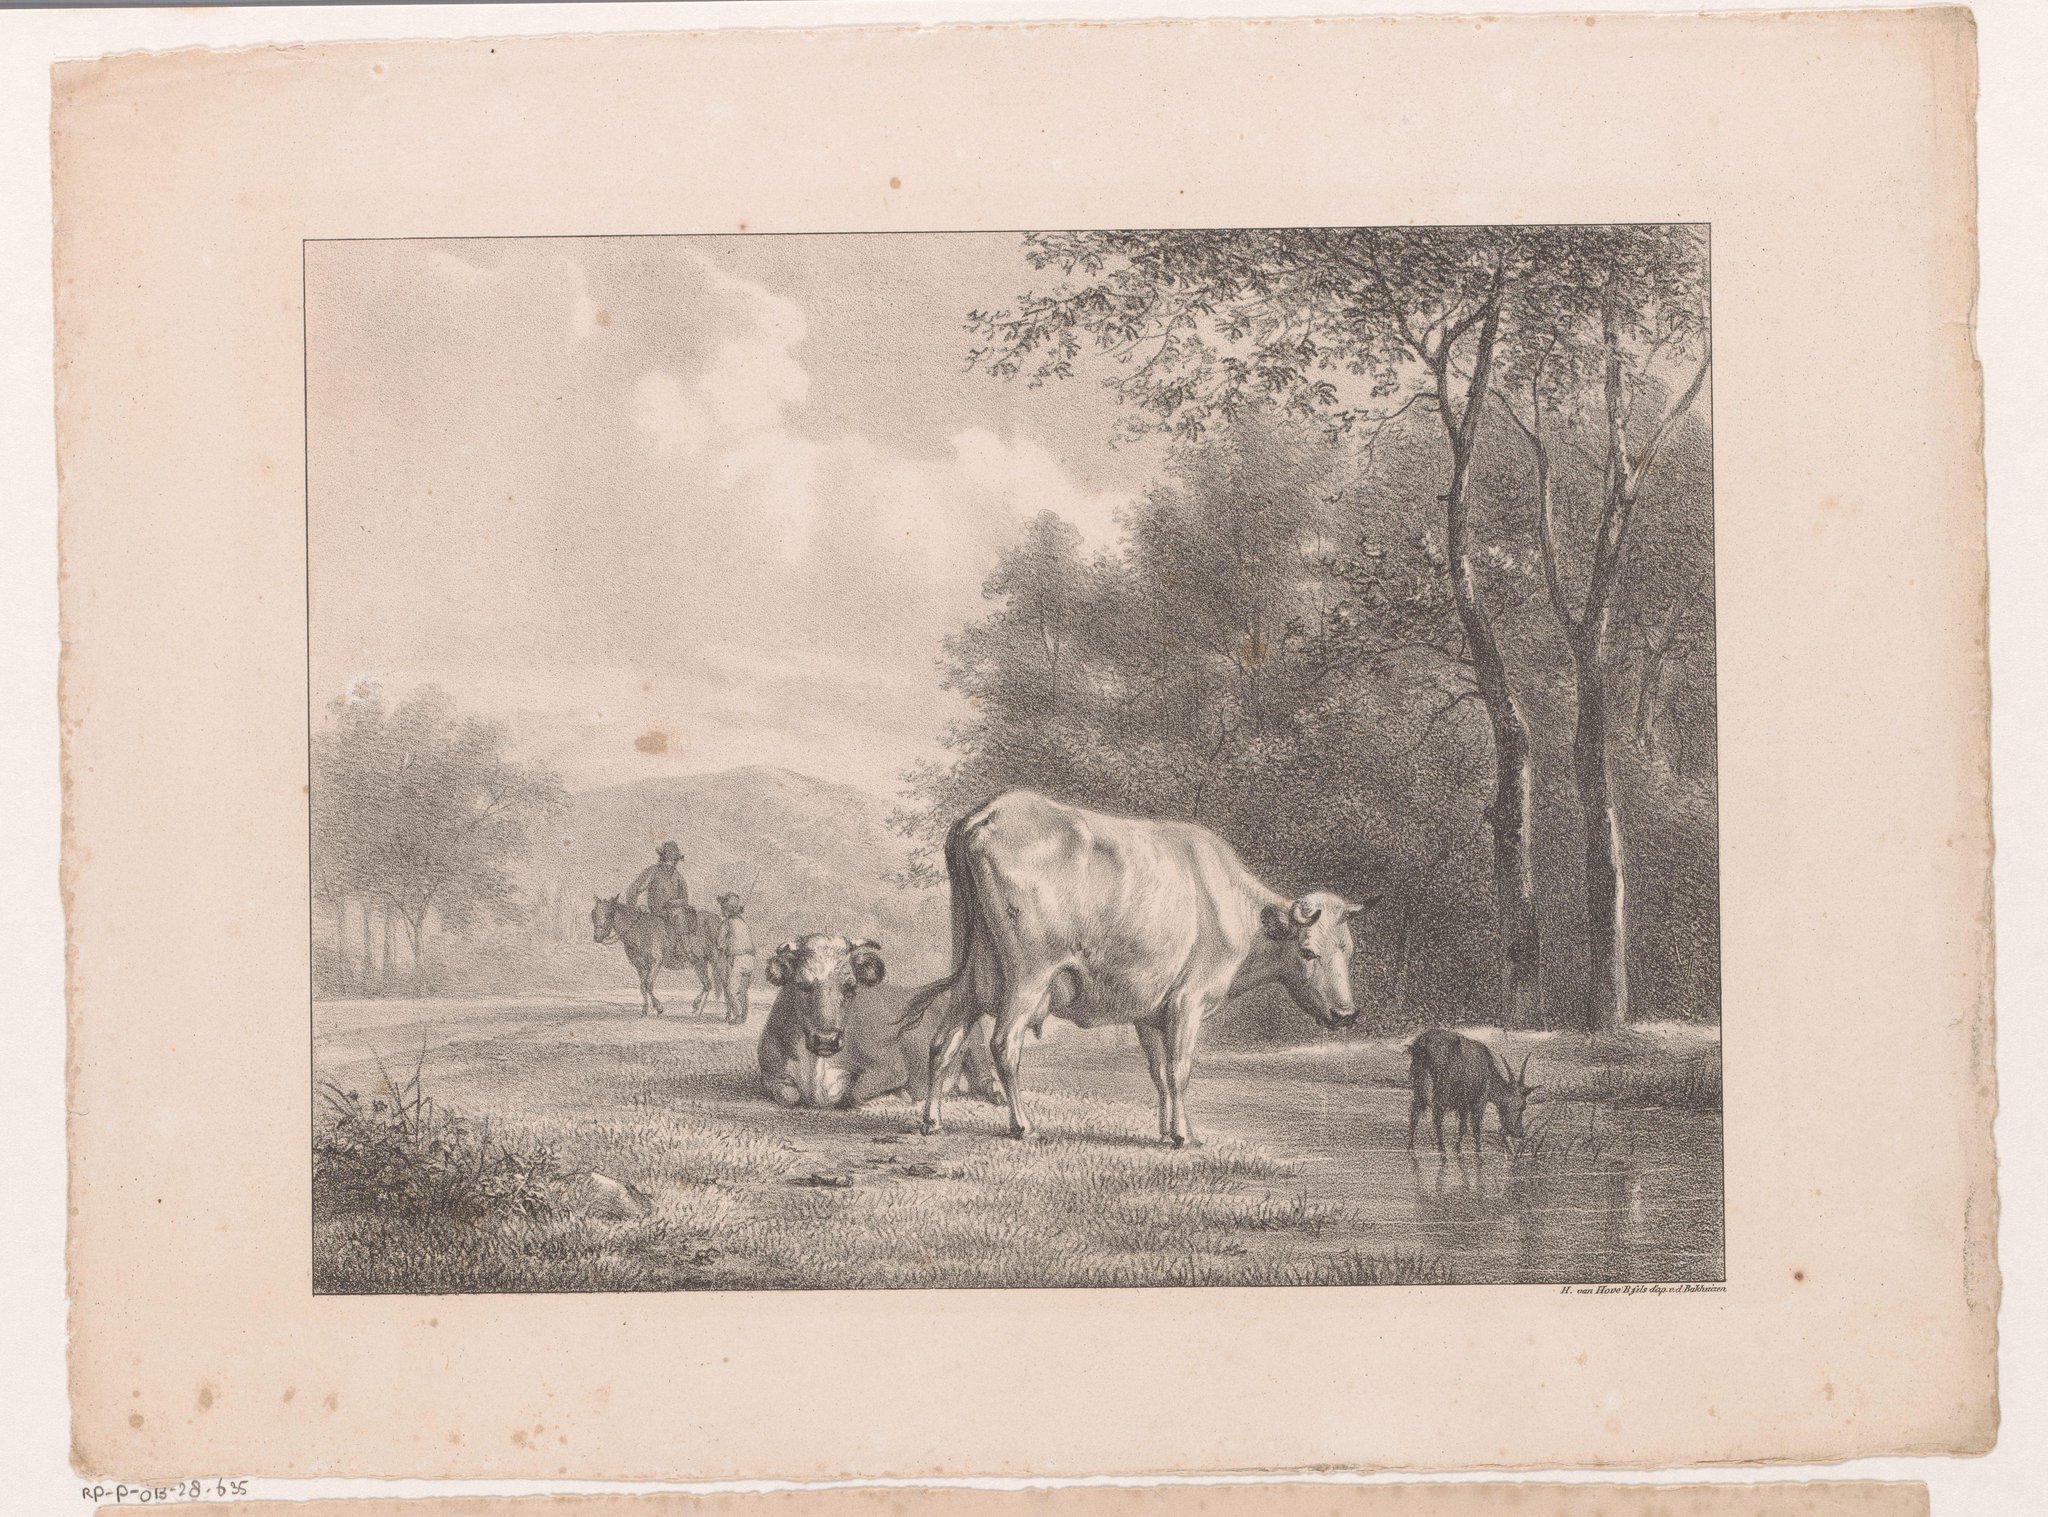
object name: print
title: Twee koeien en een geit bij een plas water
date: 1824-1867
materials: paper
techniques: lithograph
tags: cow, horse, goat, landscapes (+ landscape with figures, staffage)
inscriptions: collector's mark: Lugt 2228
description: In de achtergrond staan twee figuren in gesprek. Een van hen is te paard.